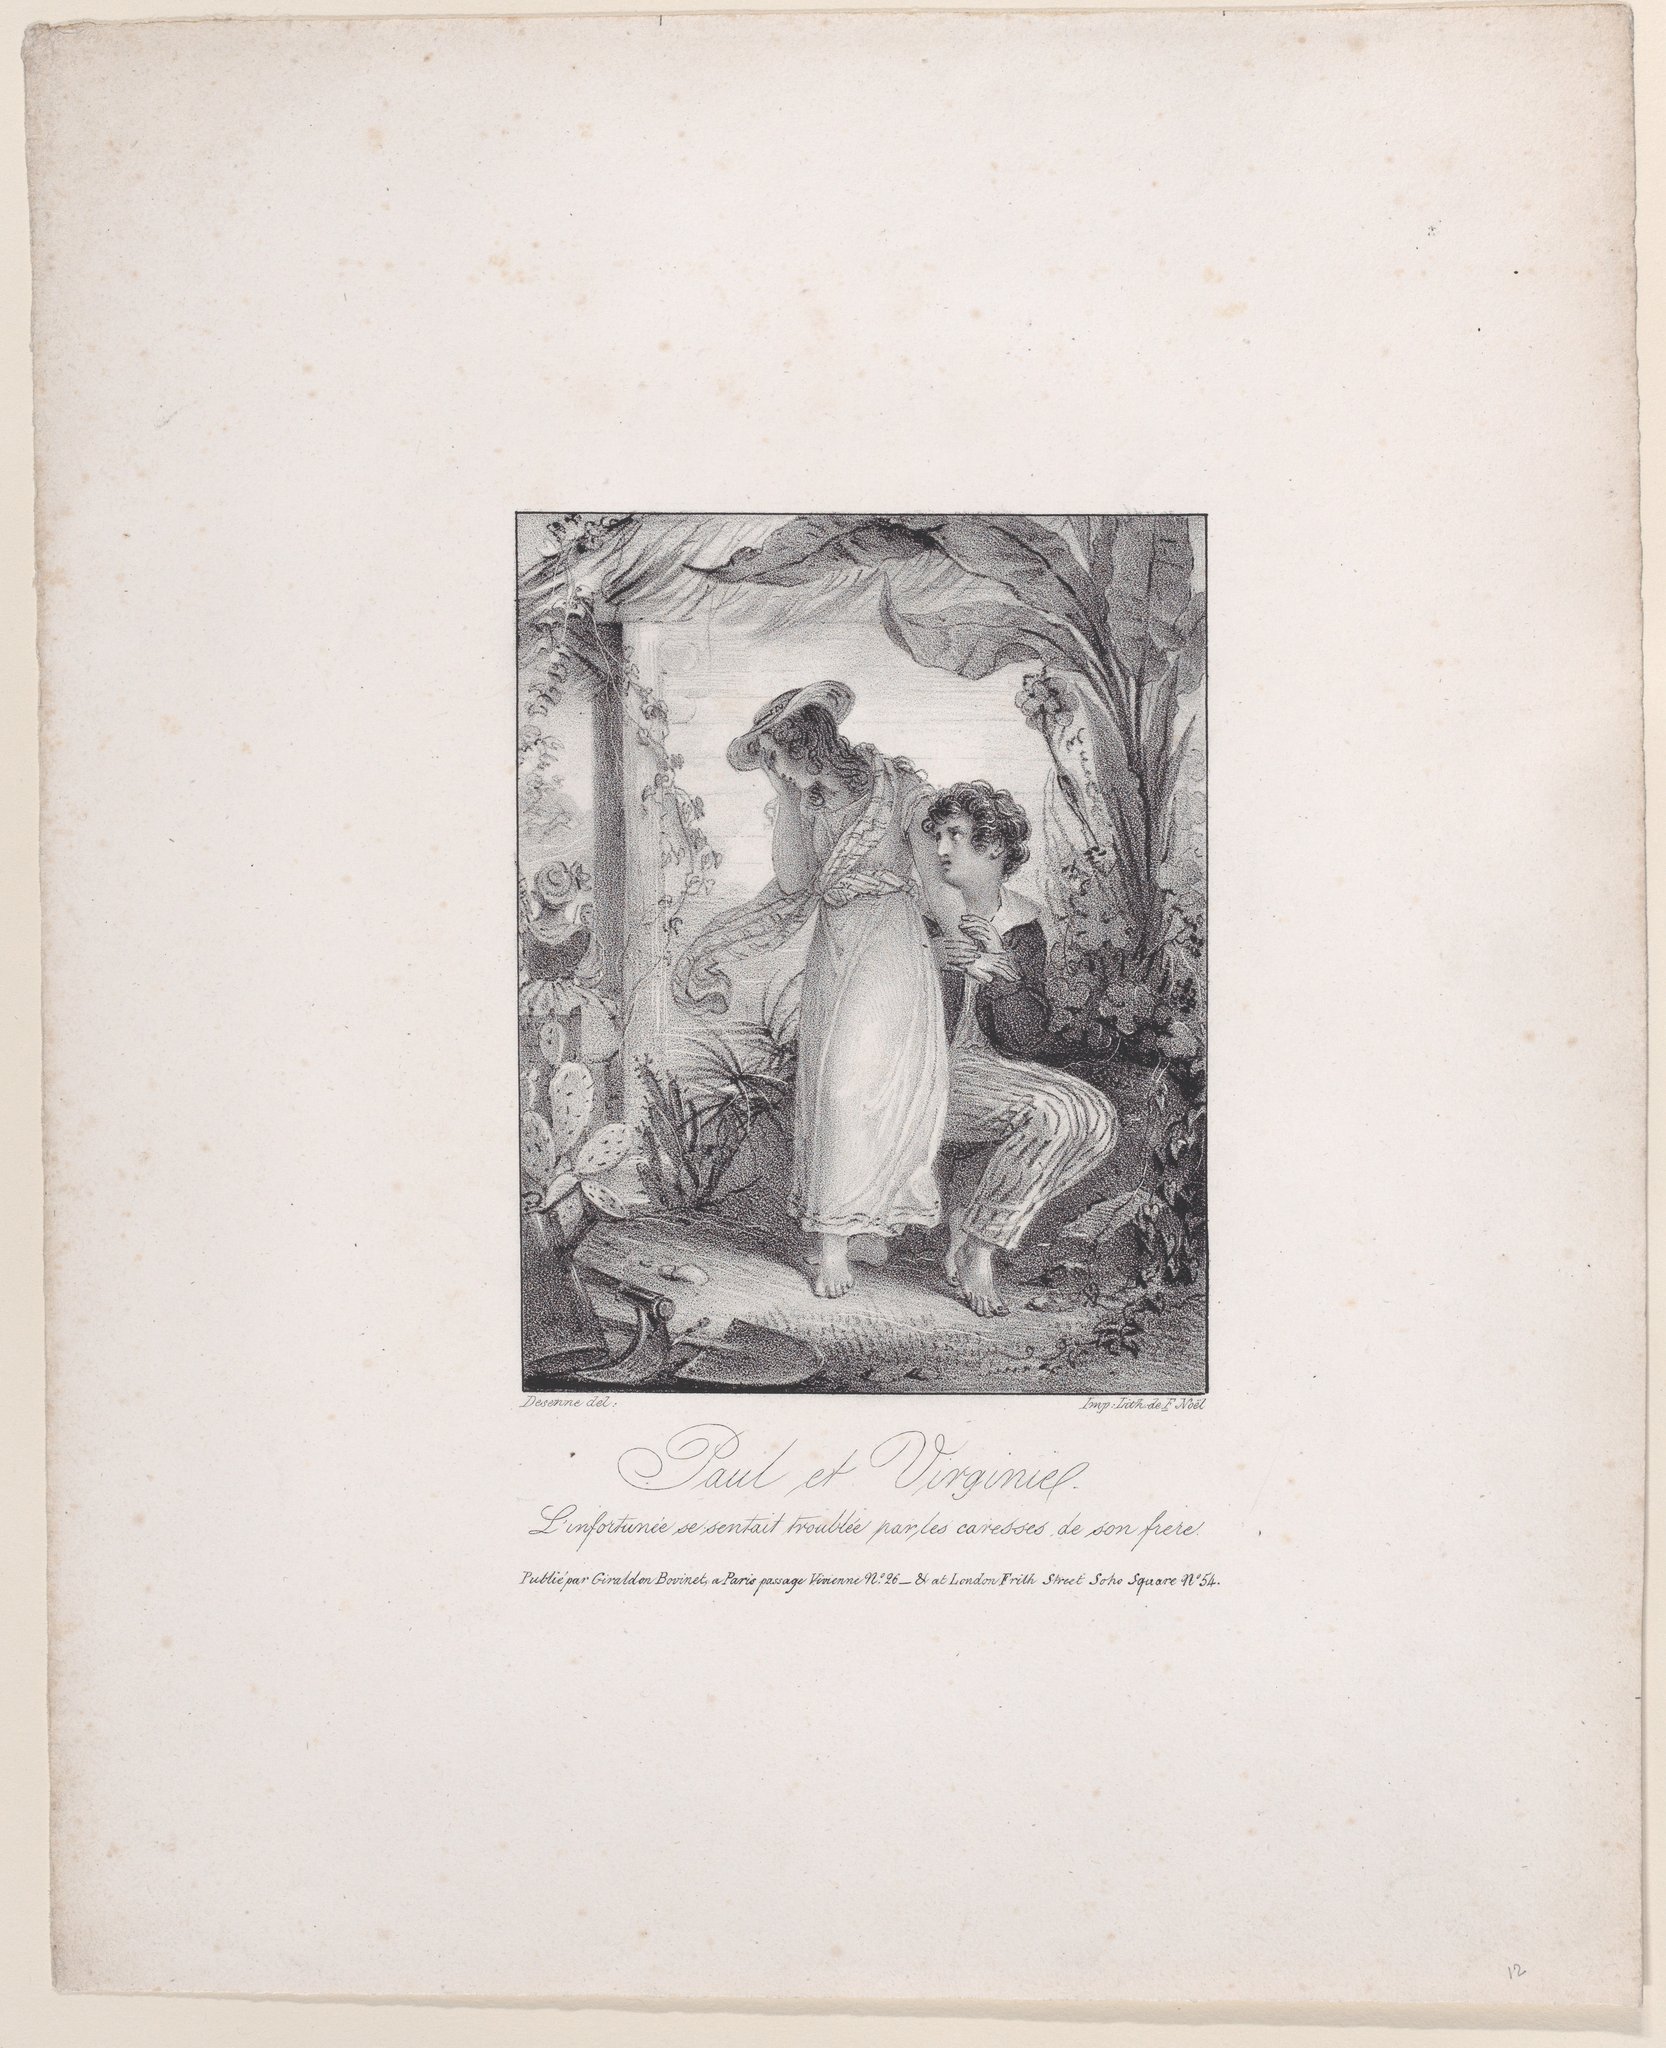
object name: print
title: Paul and Virginia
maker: alexandre joseph desenne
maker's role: artist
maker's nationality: french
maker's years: 1785-1827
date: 1805-1827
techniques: lithograph